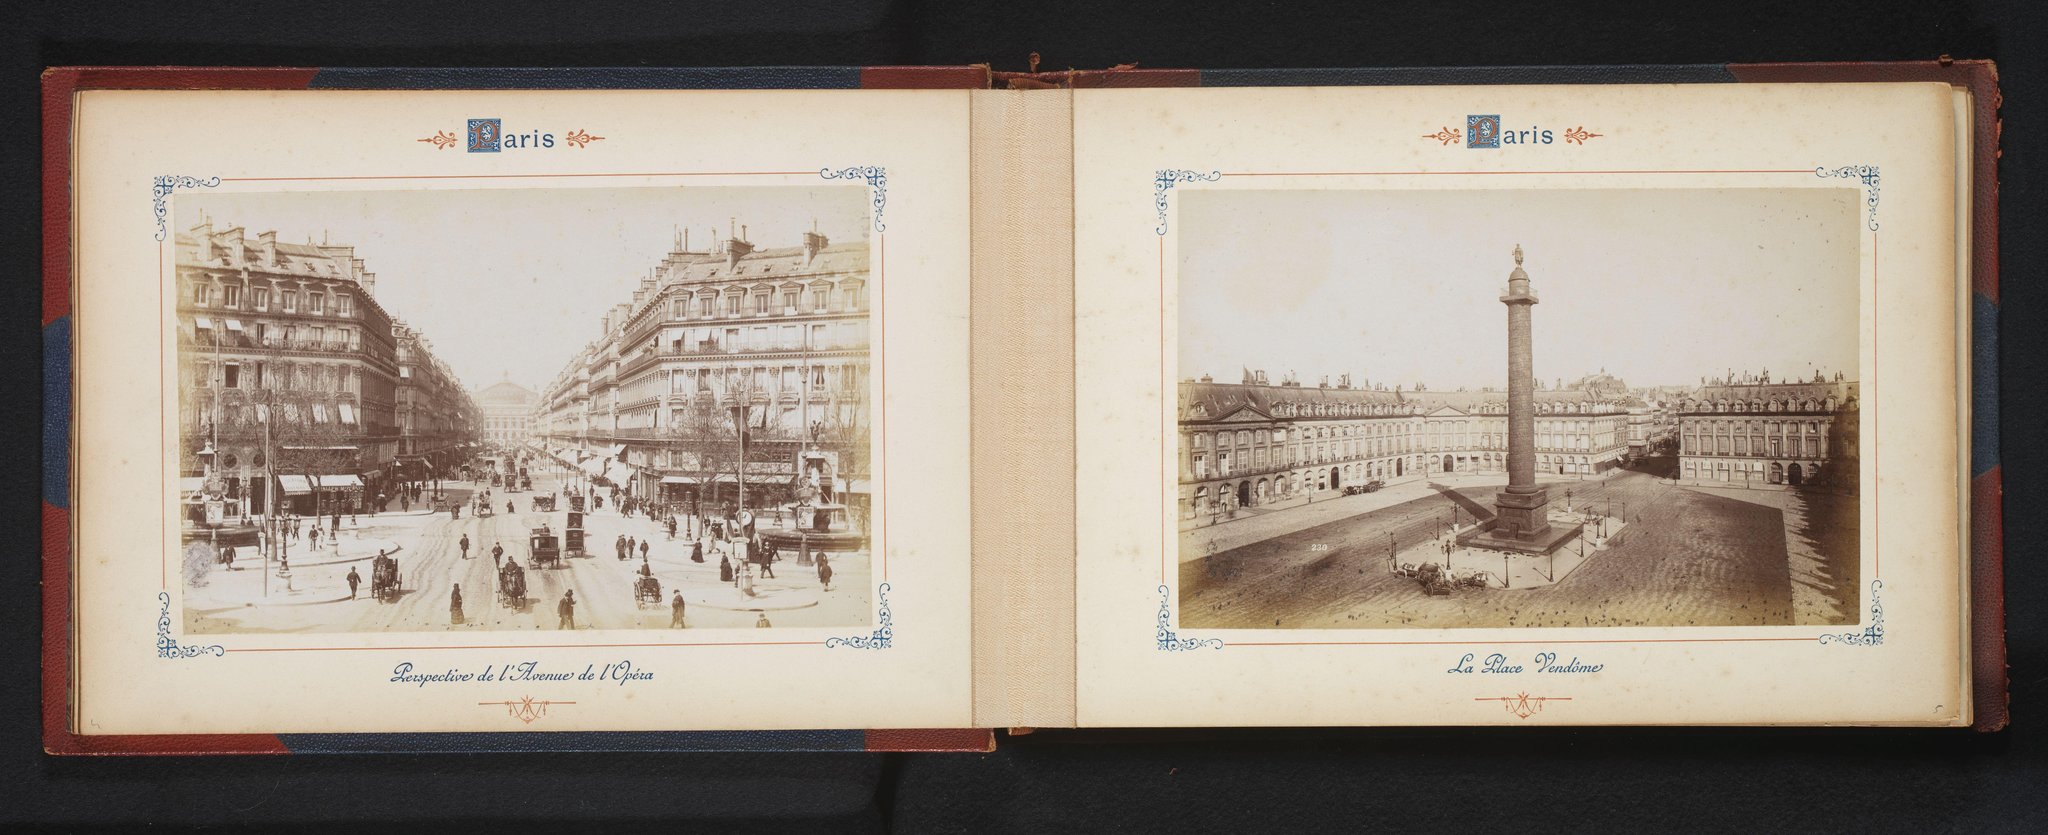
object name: page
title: Avenue de l'Opéra te Parijs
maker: Anonymous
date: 1879-1889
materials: photographic support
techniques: albumen print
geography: avenue de l'opéra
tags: four-wheeled, animal-drawn vehicle, e.g.: cab, carriage, coach, façade (of house or building), street